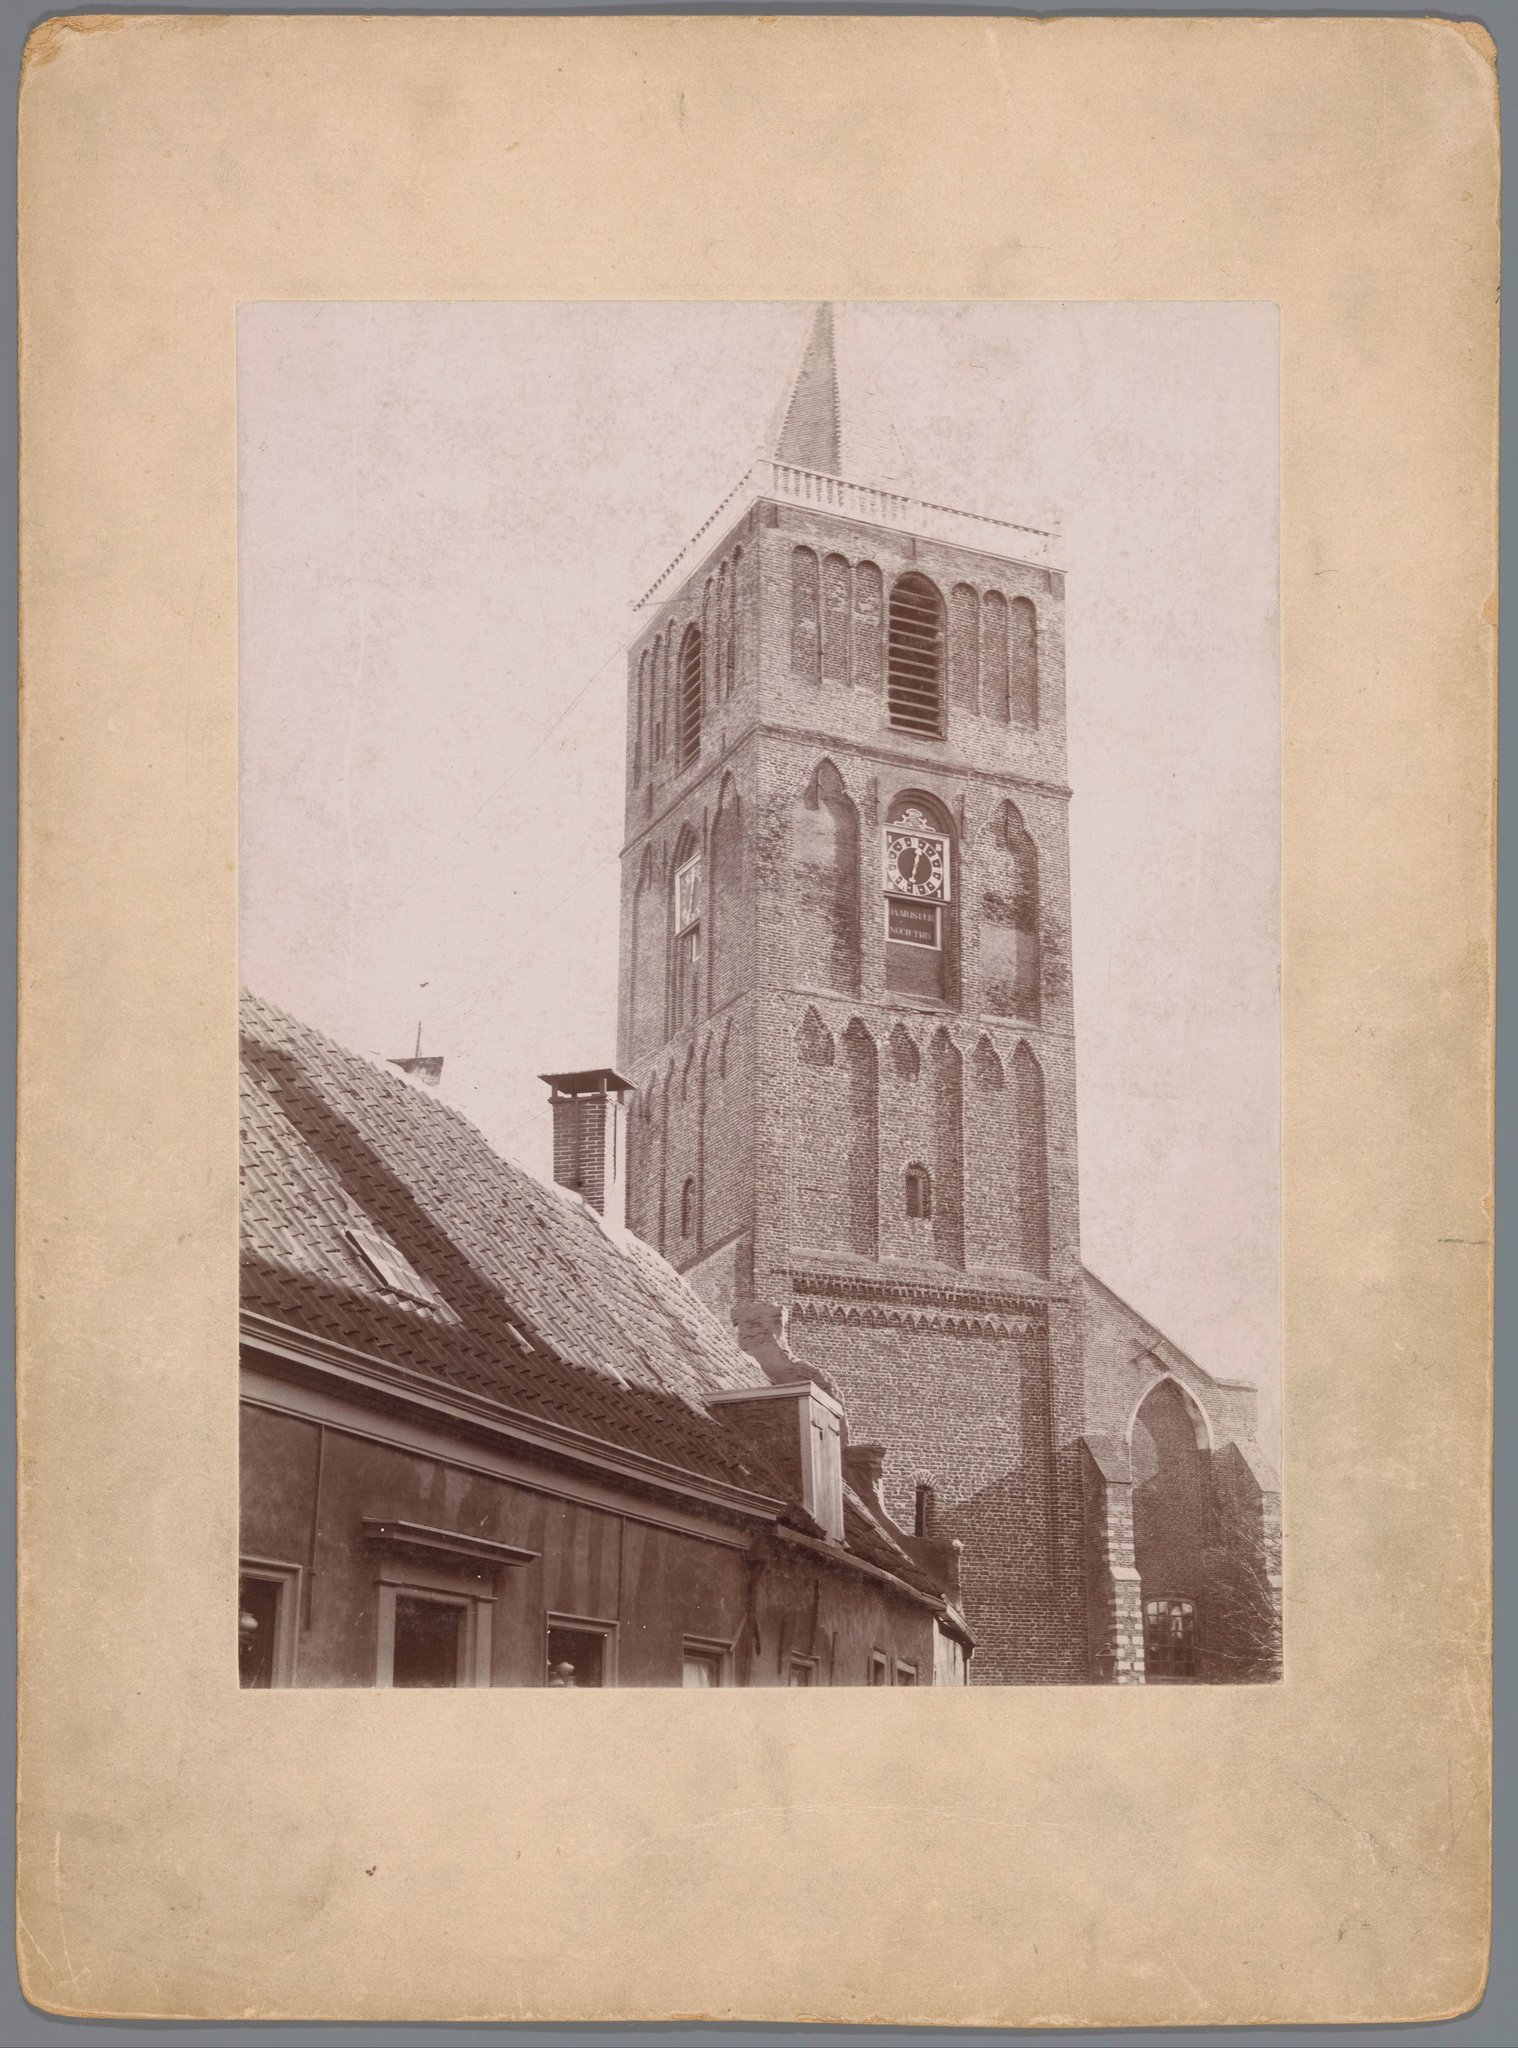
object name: photograph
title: Zicht op de toren van de Oude Jeroenskerk te Noordwijk-Binnen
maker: Anonymous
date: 1875-1900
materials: cardboard, photographic support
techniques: daylight paper print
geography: noordwijk-binnen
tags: façade (of house or building), parts of church exterior and annexes: tower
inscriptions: inscription: ‘Toren te Noordwijk binnen’, collector's mark: Lugt 3937